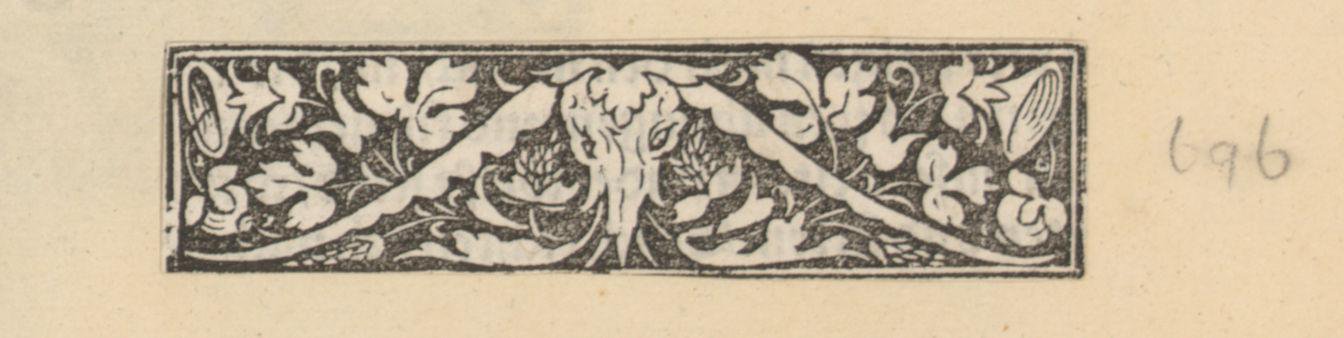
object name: album leaf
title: Schedel met hoorns en ornamenten met bladmotief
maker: Anonymous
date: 1514-1532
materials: paper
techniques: letterpress printing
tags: foliage ~ ornament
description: Deze prent is gebruikt als ornament in: Petrarca, Francesco. Von der Artzney bayder Glück, des guten und widerwertigen: unnd weß sich ain yeder inn Gelück und Unglück halten sol (...). Augsburg: Heinrich Steiner, 1532. Deze uitgave is ook bekend onder de titel 'Trostspiegel in Glück und Unglück'.